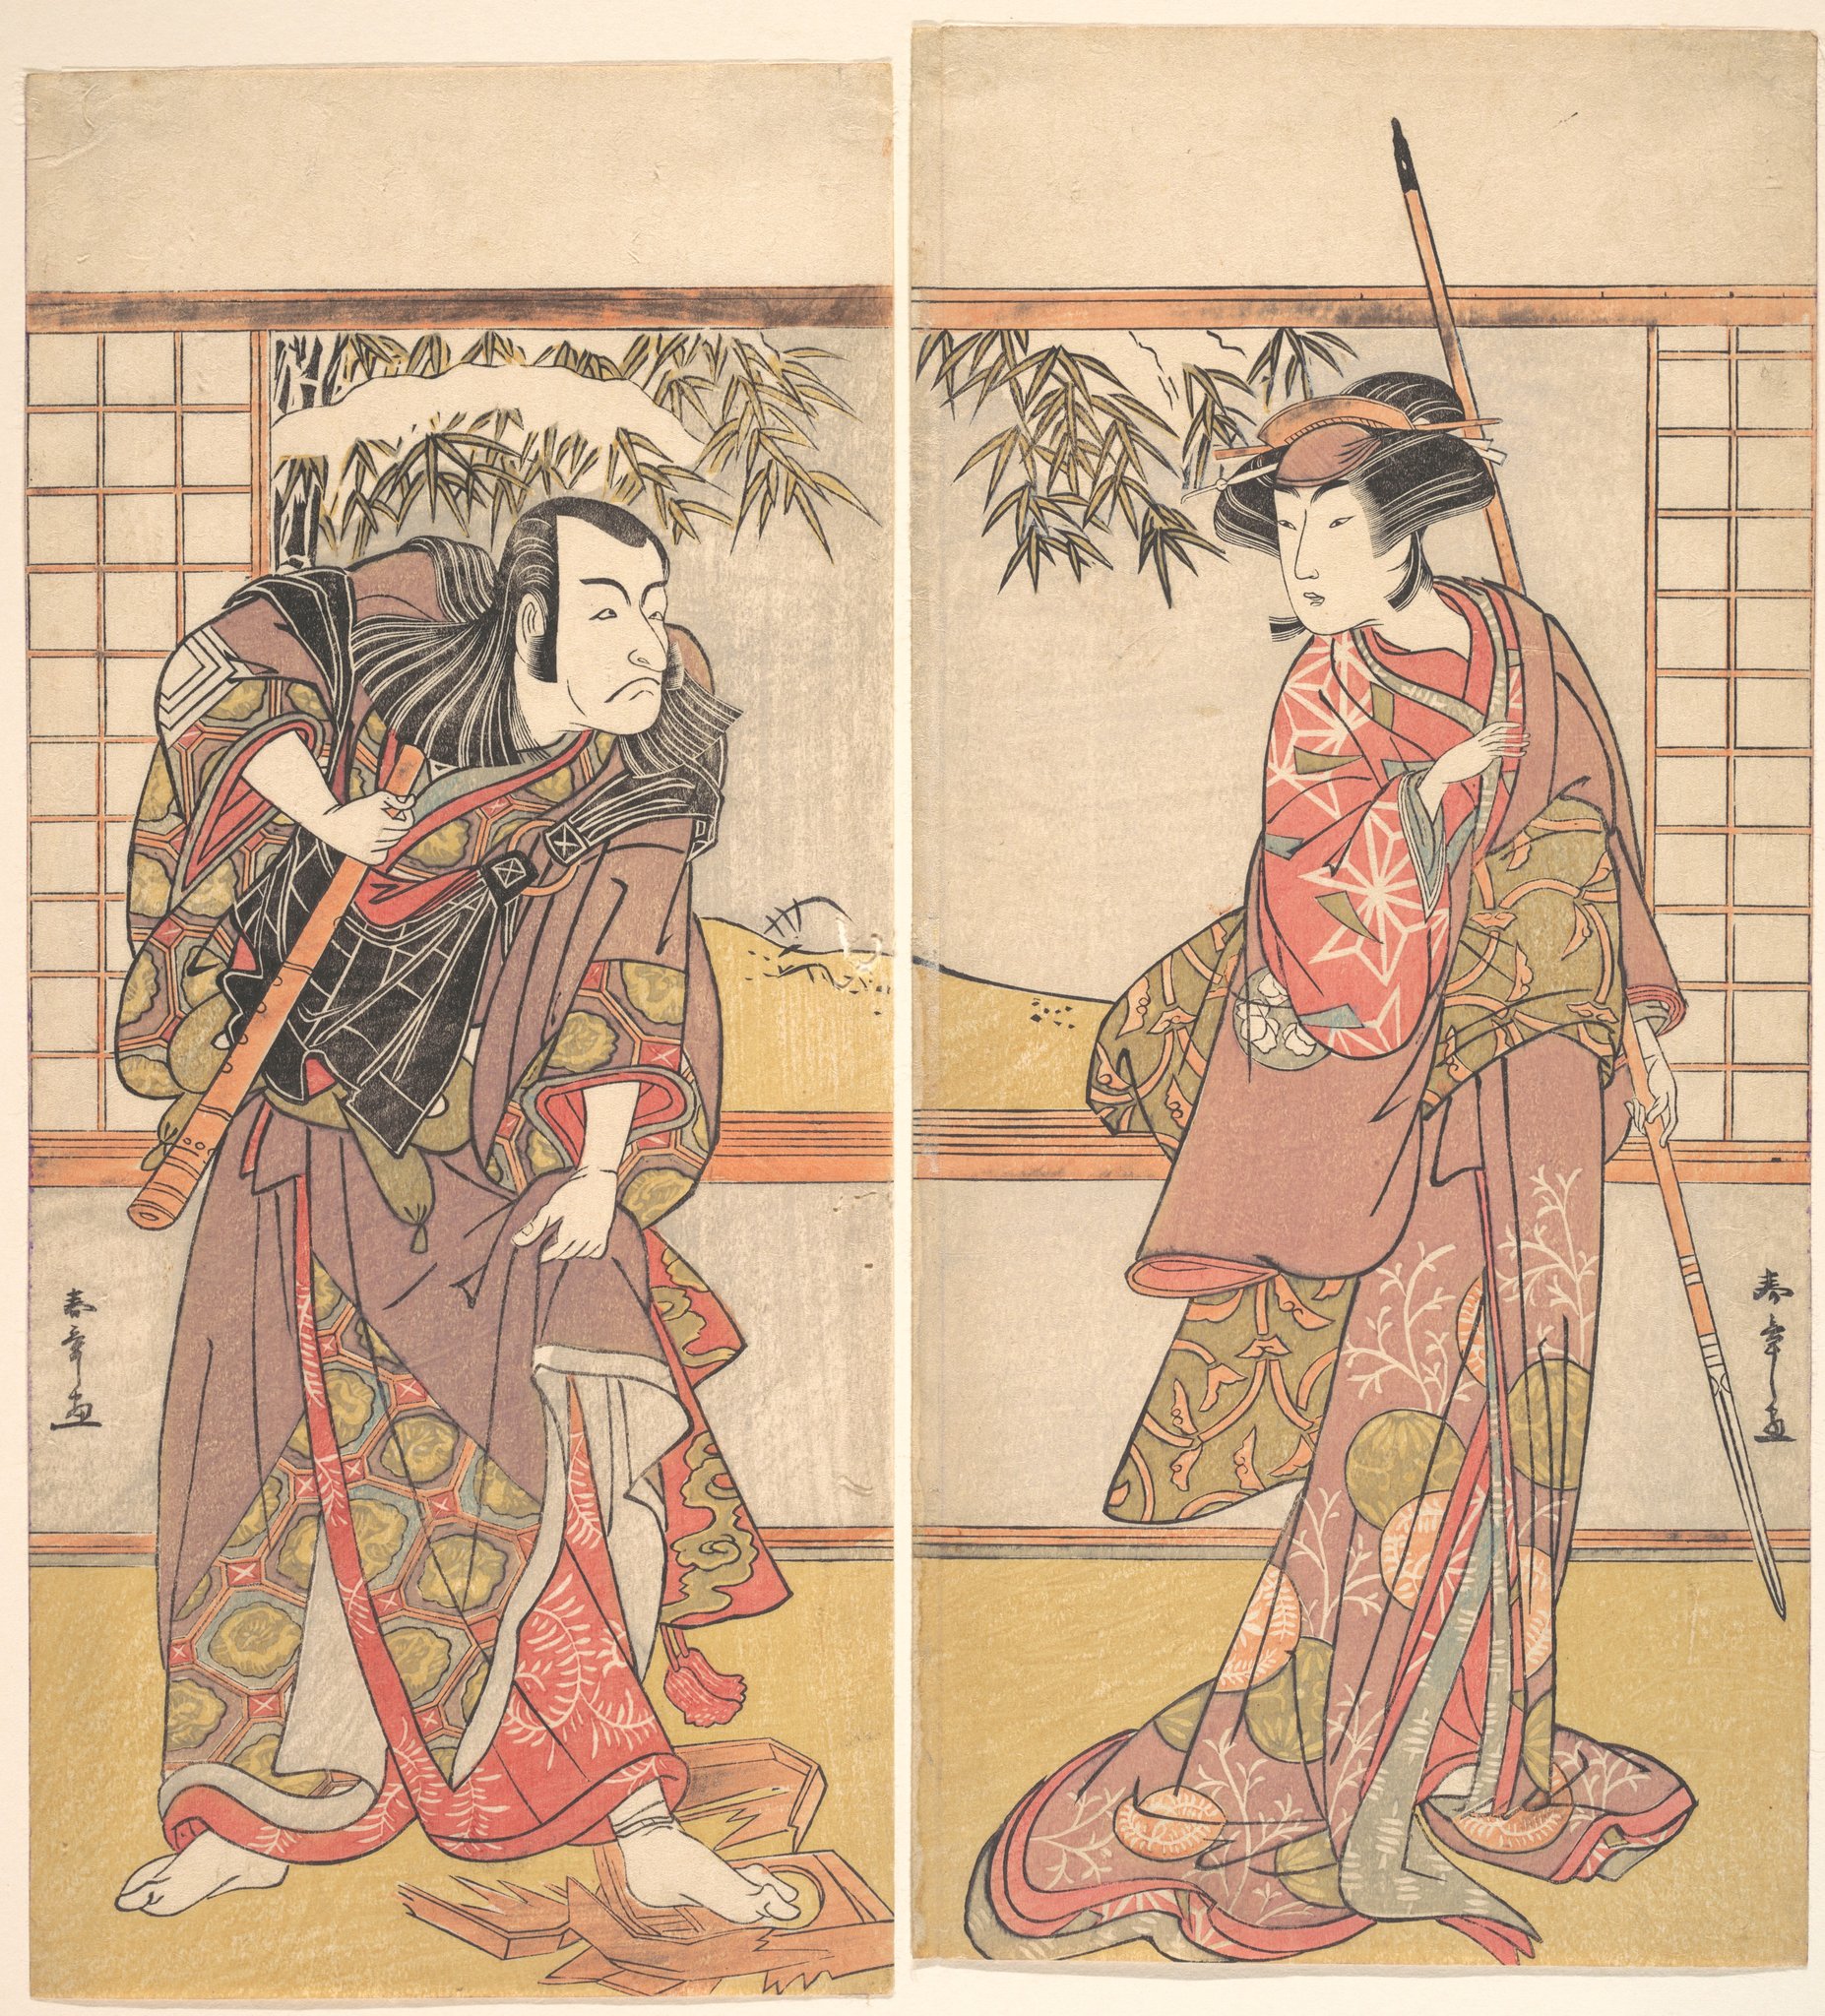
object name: woodblock print nishiki e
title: Kabuki Actors Osagawa Tsuneyo II and Ichikawa Danjūrō V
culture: japanese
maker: katsukawa shunshō 勝川春章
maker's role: artist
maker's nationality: japanese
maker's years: 1726-1792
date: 1780-1789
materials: ink, paper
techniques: nishiki e, woodblock print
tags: weapons,men,actors